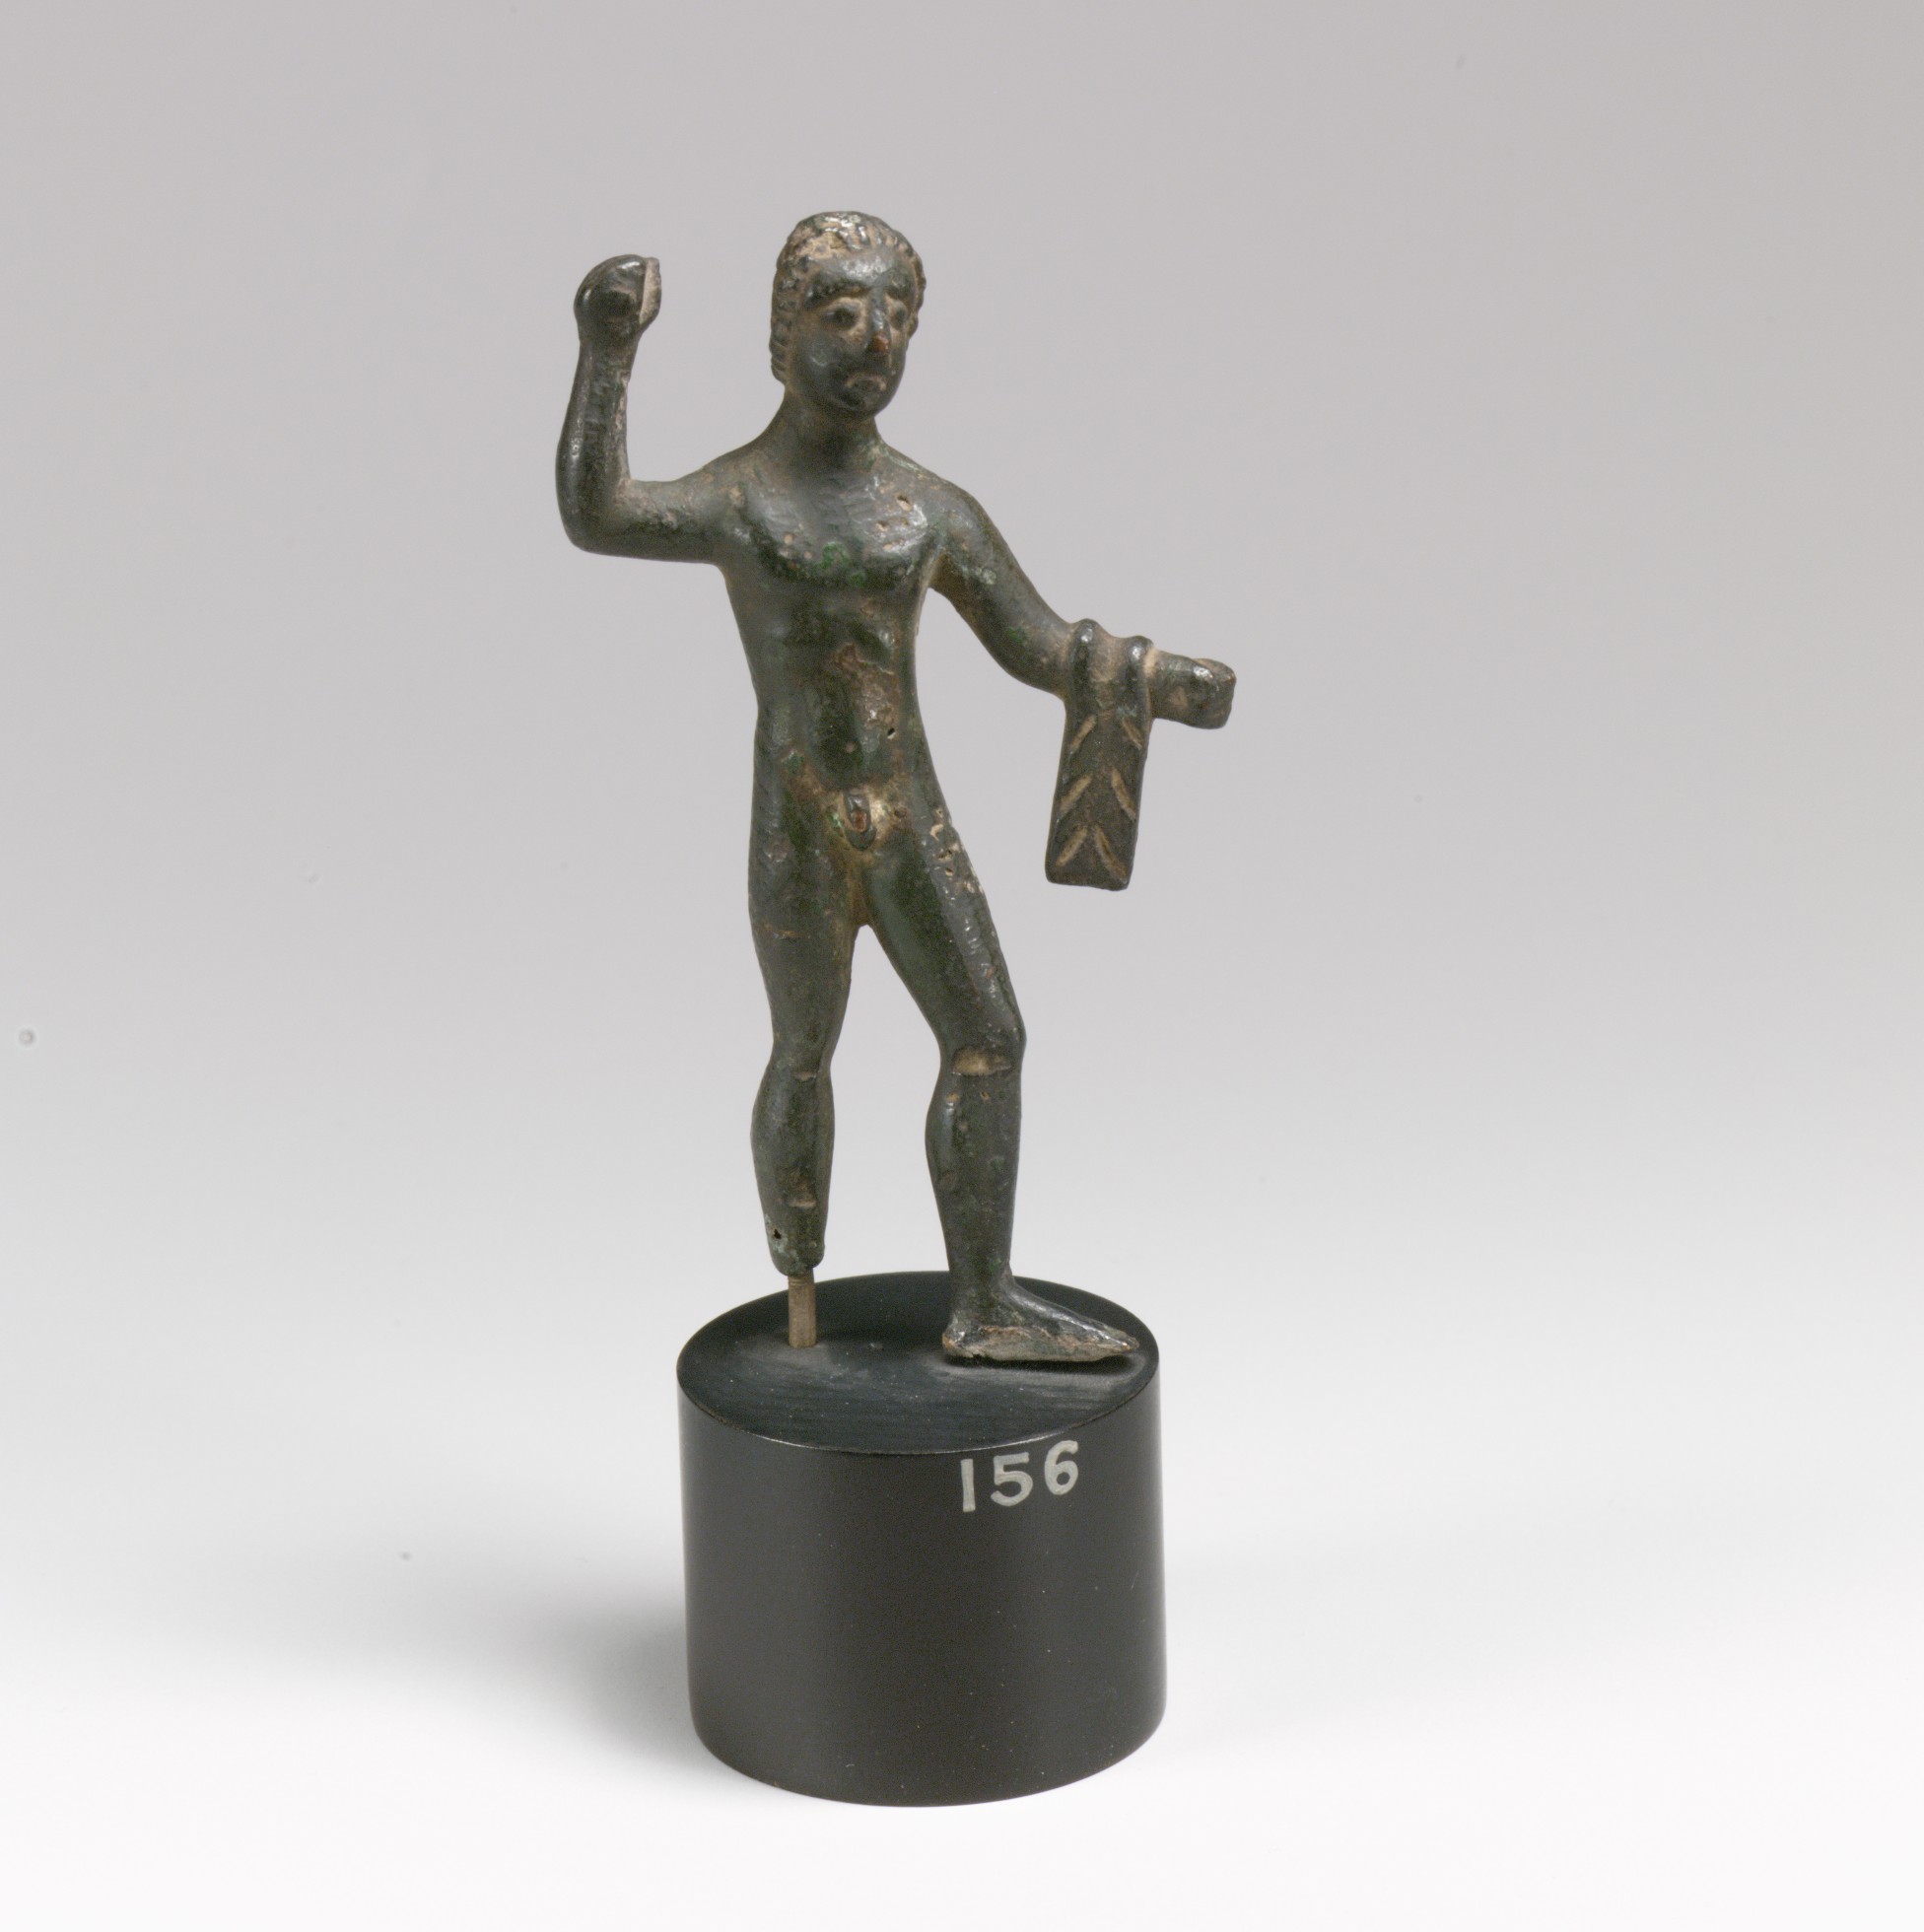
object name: statuette of herakles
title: Bronze statuette of Herakles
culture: italic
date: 300-1 BCE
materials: bronze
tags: male nudes,herakles